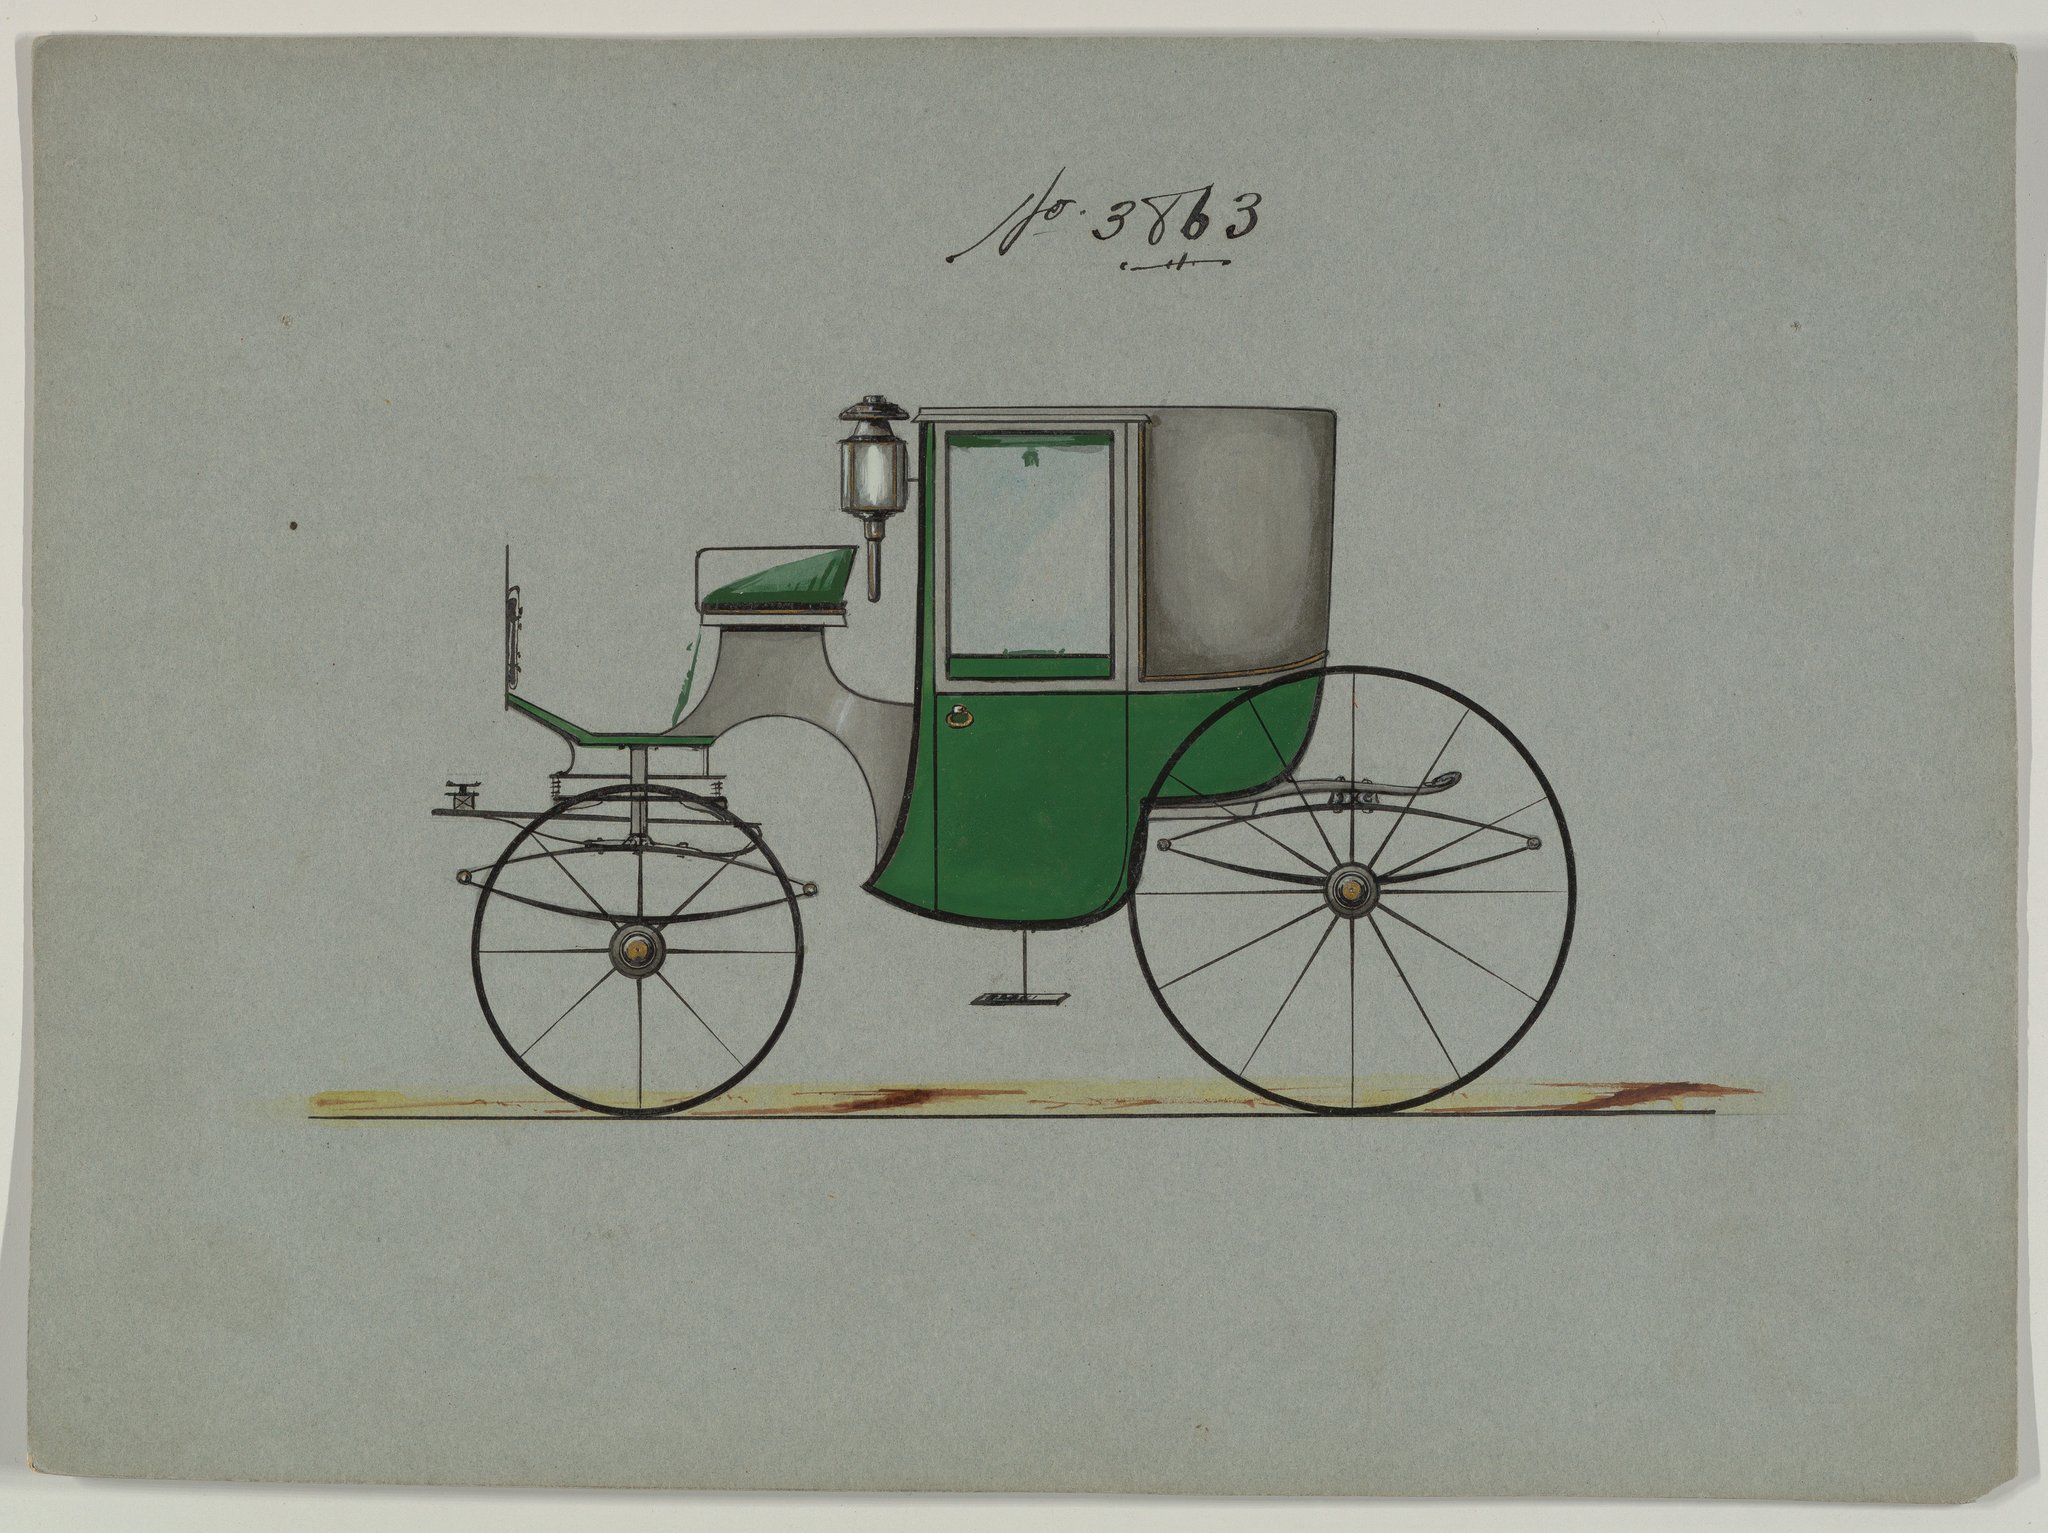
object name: drawing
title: Brougham #3863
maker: brewster & co.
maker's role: manufacturer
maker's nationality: american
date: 1883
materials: gouache, ink, watercolor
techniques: pen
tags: carriages